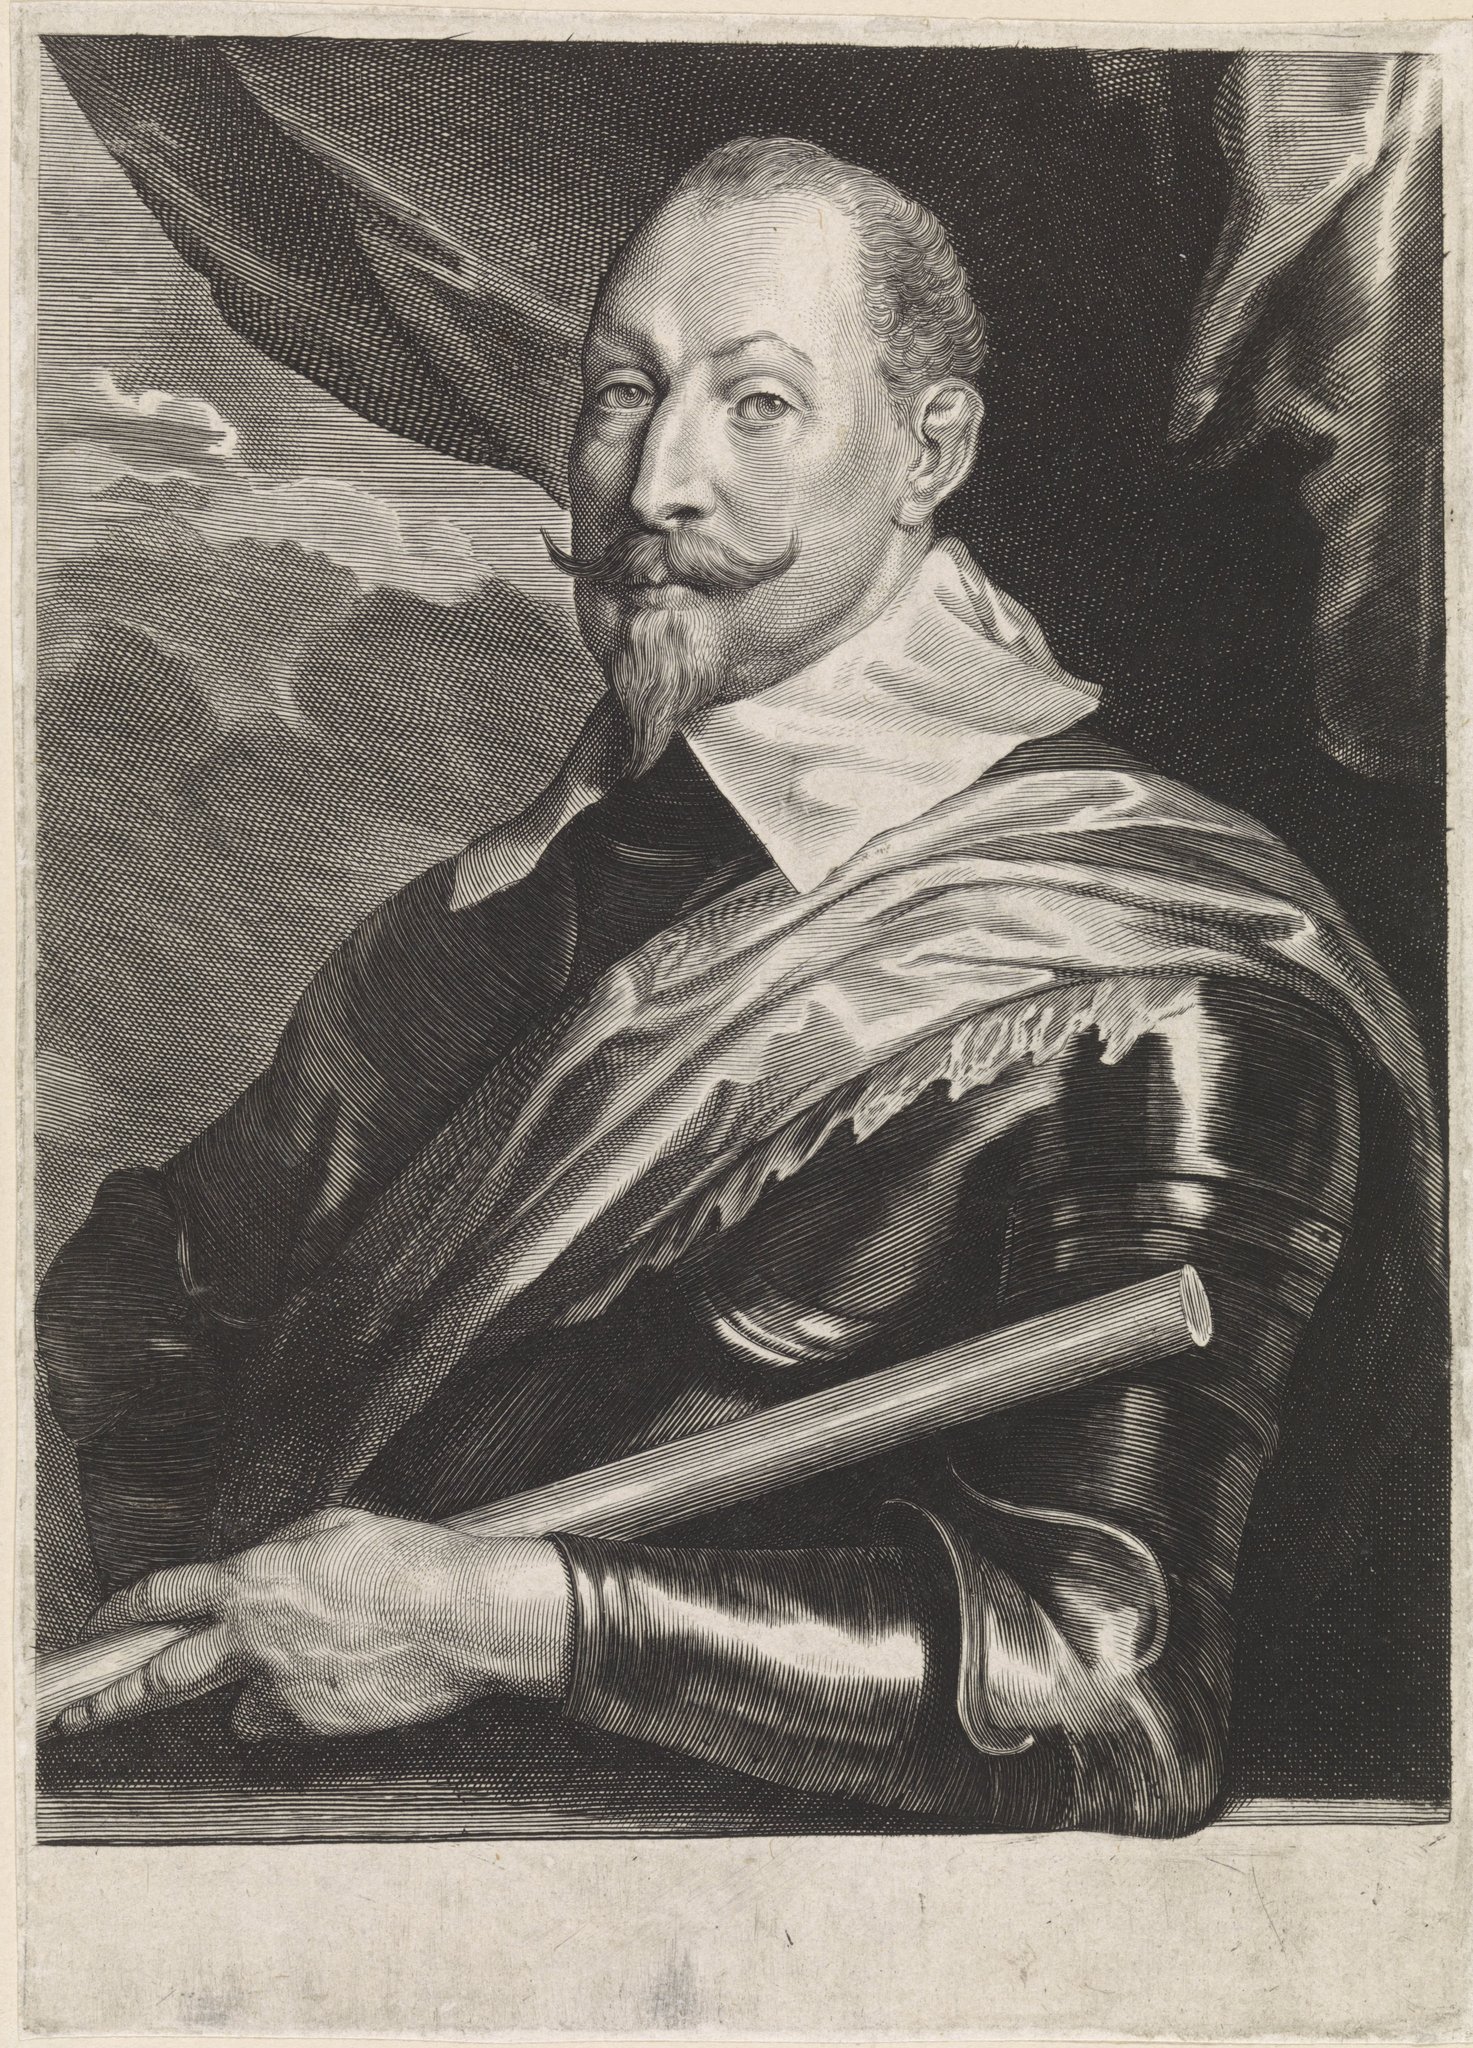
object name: print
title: Portret van Gustaaf II Adolf, koning van Zweden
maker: paulus pontius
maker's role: draughtsman, print maker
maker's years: 1603-1658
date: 1616-1657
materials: paper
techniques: engraving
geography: antwerp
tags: armour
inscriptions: collector's mark: Lugt 240